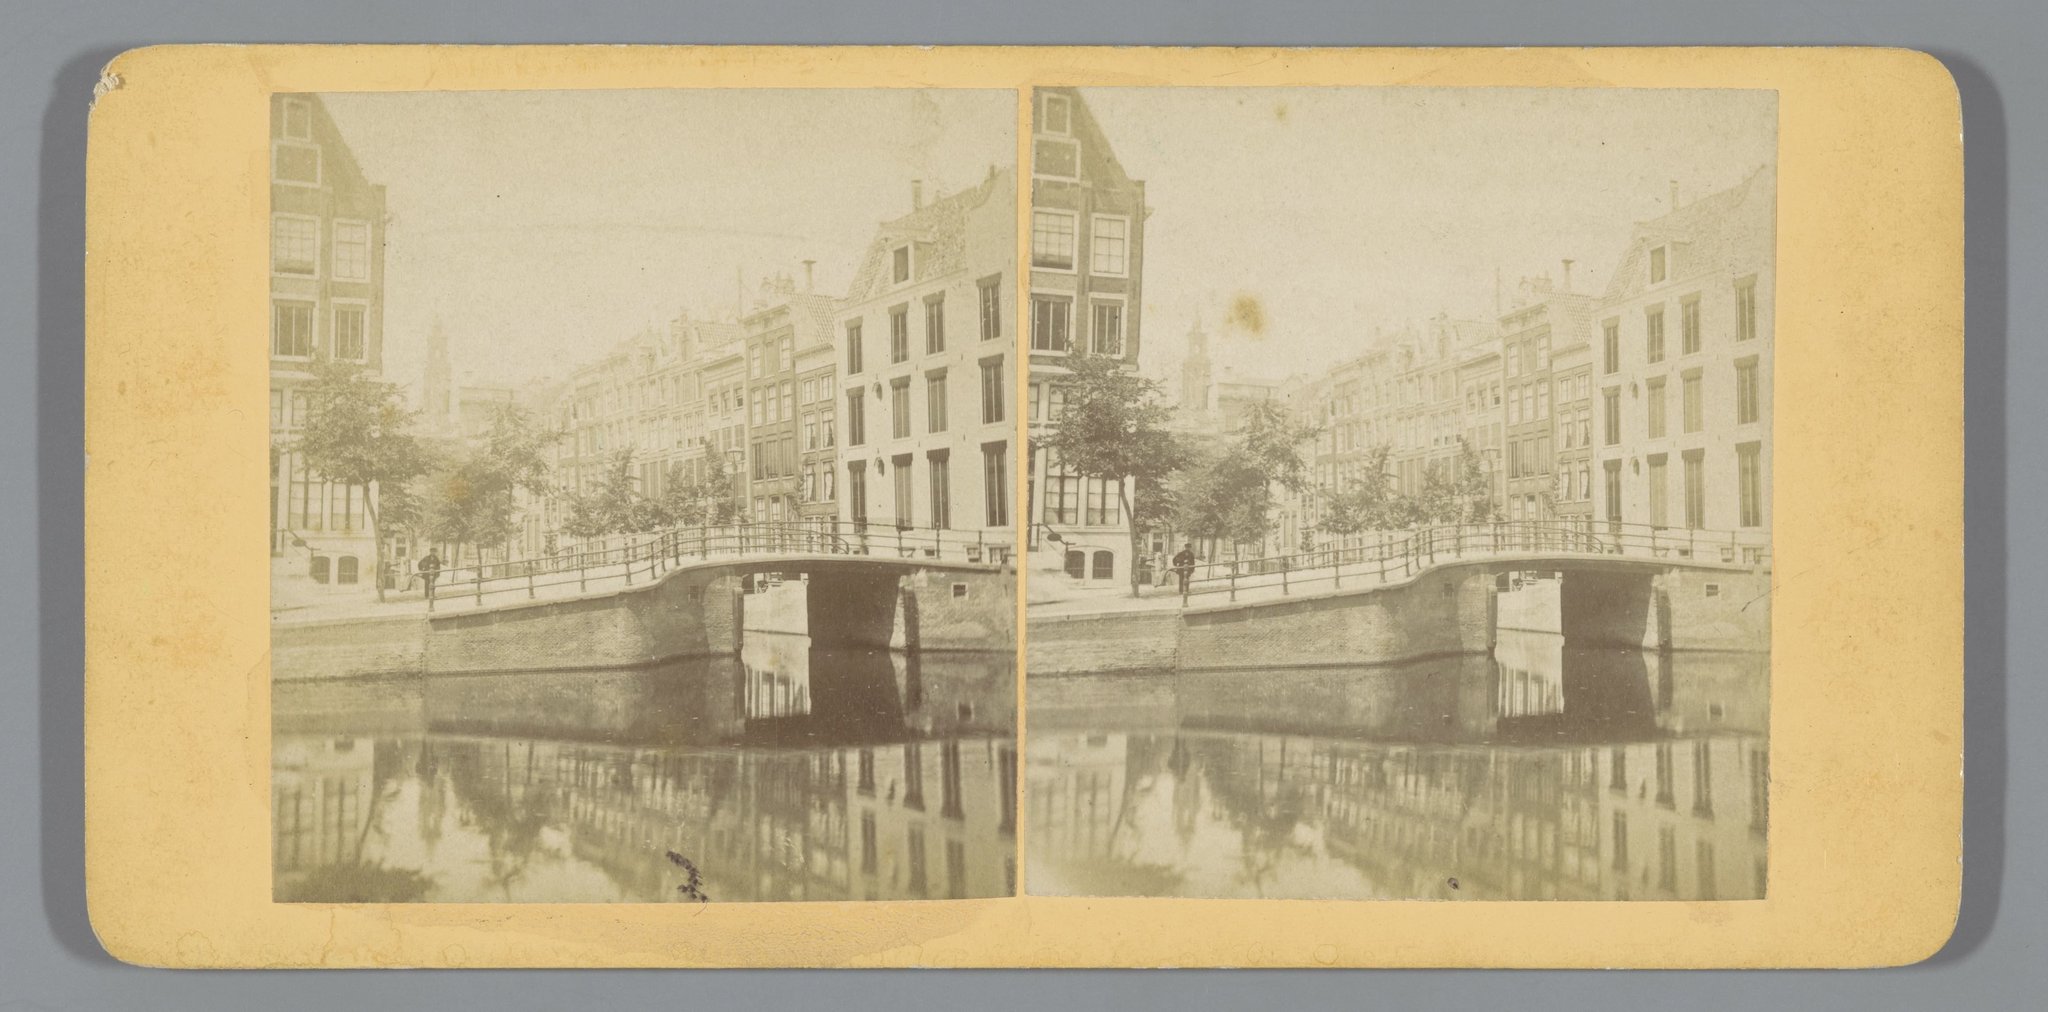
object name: stereograph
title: Warmoesgracht in Amsterdam, gezien vanaf de Singel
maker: Anonymous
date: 1868-1890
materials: cardboard, paper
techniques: albumen print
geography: amsterdam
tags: canals, waters (in city), bridge in city across river, canal, etc.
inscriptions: inscription: ‘50 Amsterdam/ Warmoesgracht’